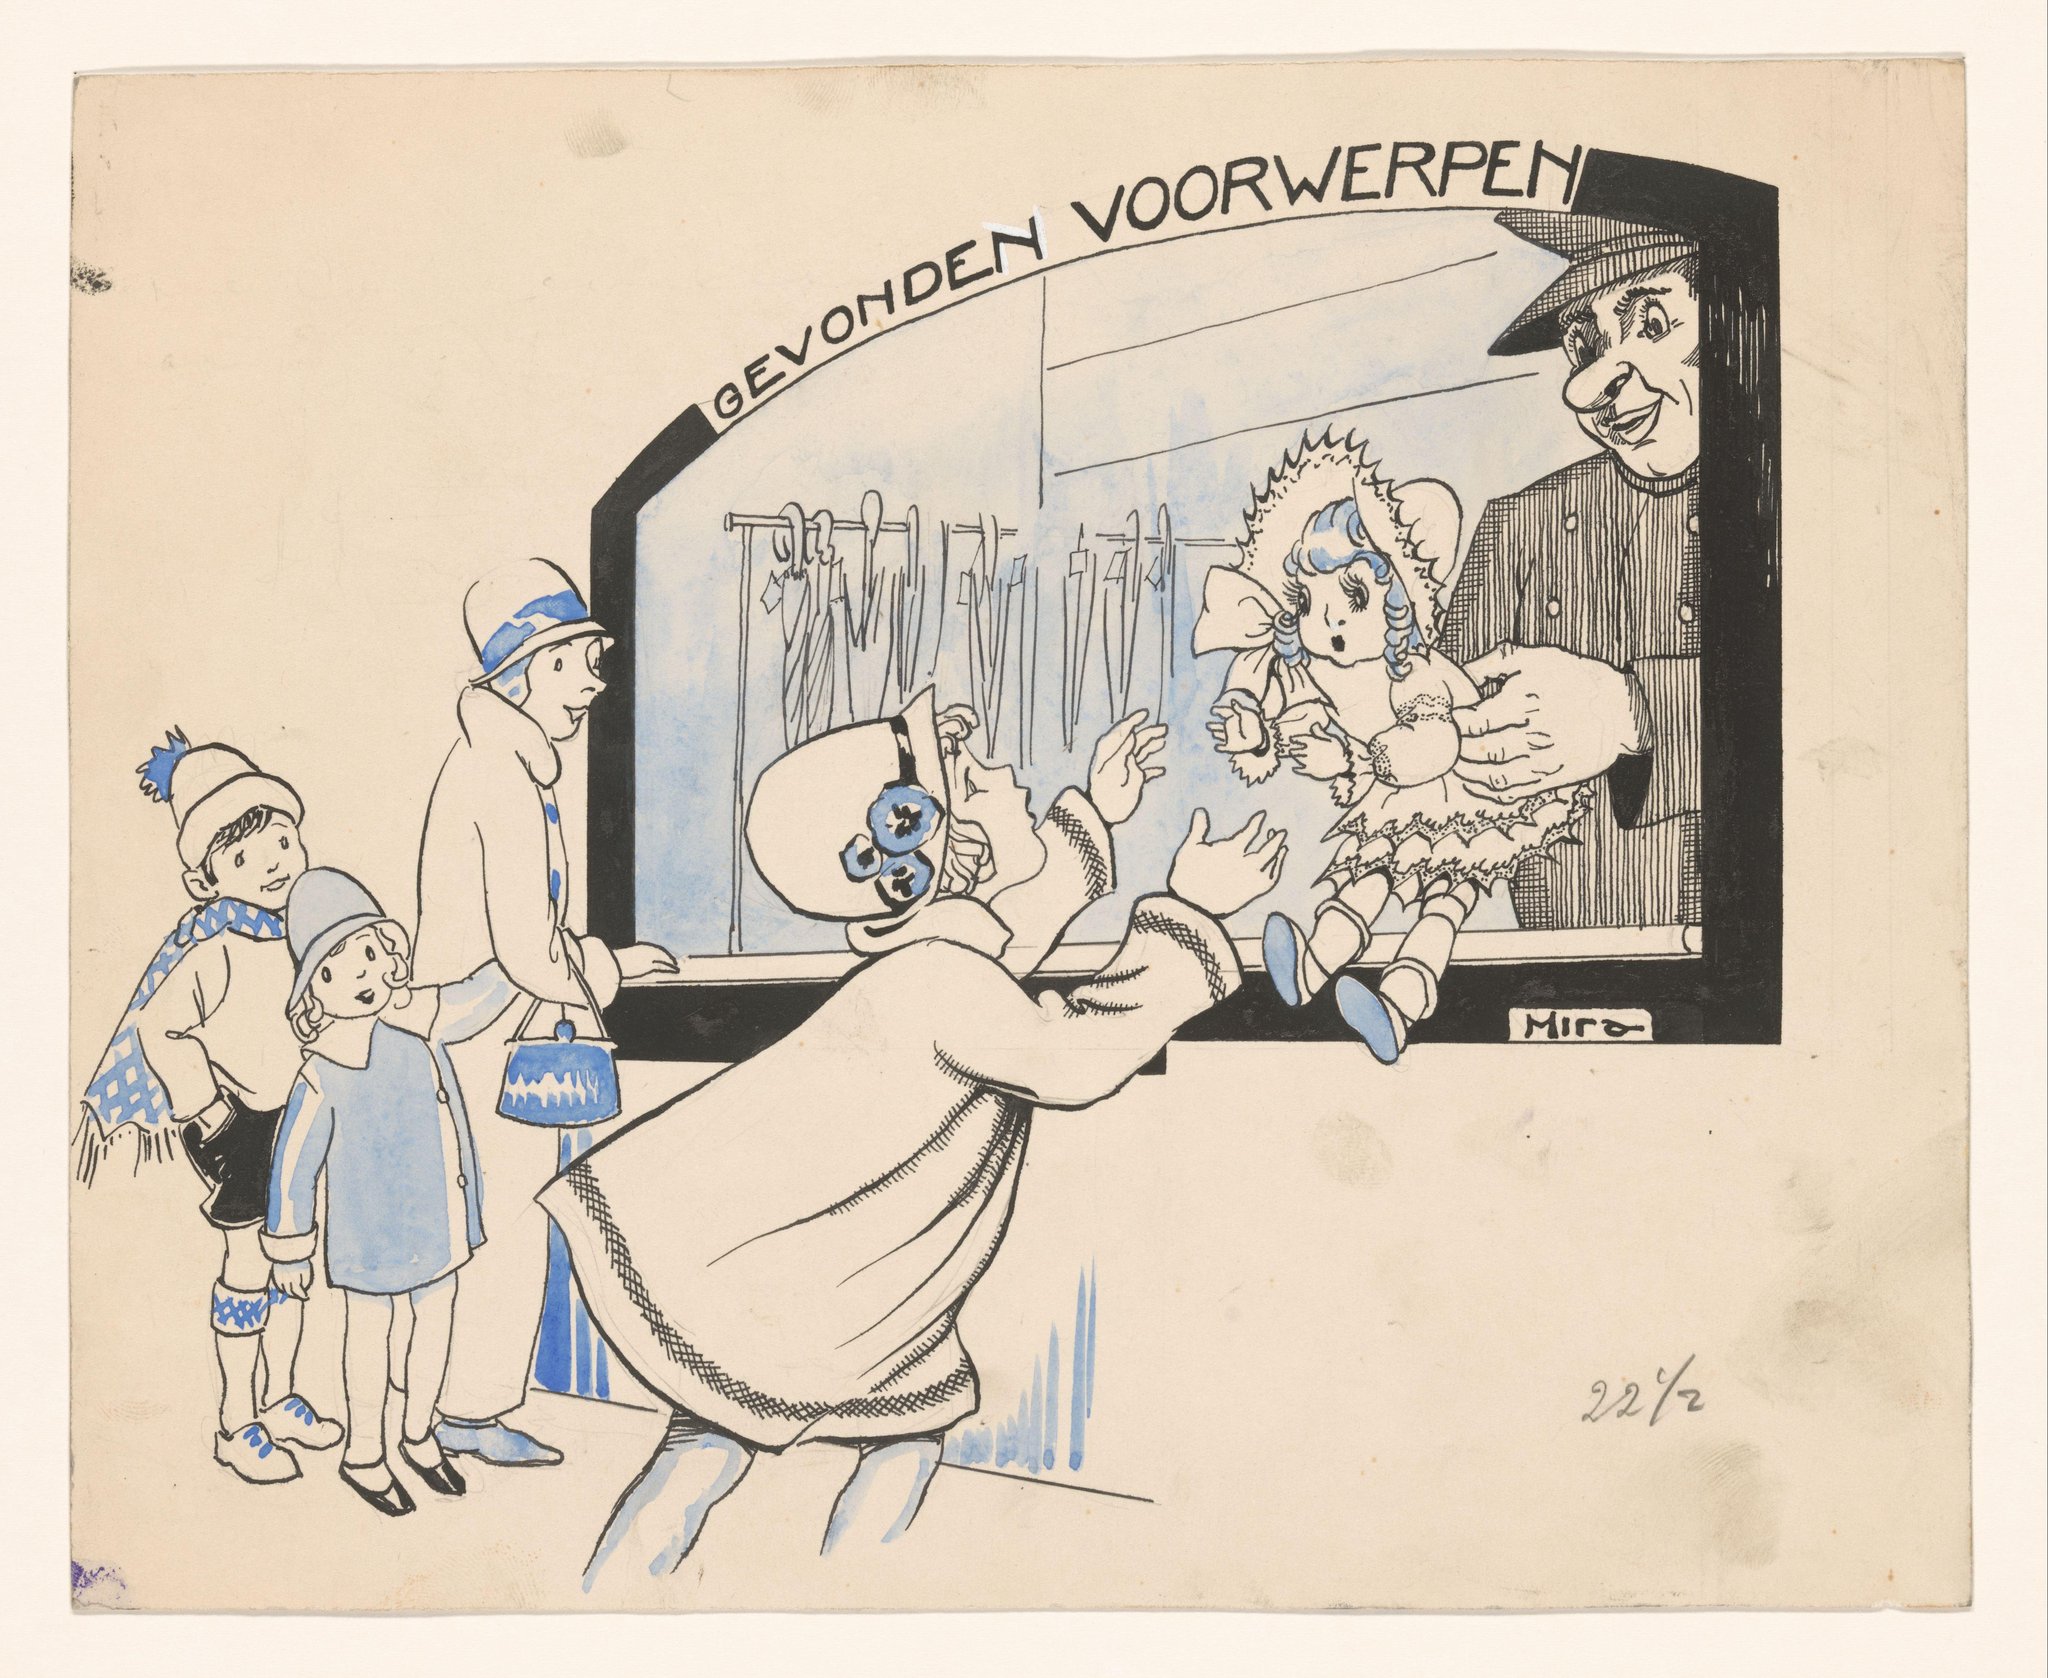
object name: illustratie ontwerp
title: Meisje haalt pop op bij loket Gevonden Voorwerpen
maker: mira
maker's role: draughtsman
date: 1852-1905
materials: paint, ink, paper, pencil, watercolor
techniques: brush, pen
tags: (playing with) dolls, open window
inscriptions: signature: ‘Mira’, annotation:, collector's mark: ‘Spoed/ De KinderCourant/ O.Z Achterburgwal 175/ Amsterdam’ Lugt 2228a, :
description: Een meisje neemt haar pop aan van een man die bij het loket Gevonden Voorwerpen werkt. In de achtergrond staan een vrouw, jongen en meisje glimlachend toe te kijken.